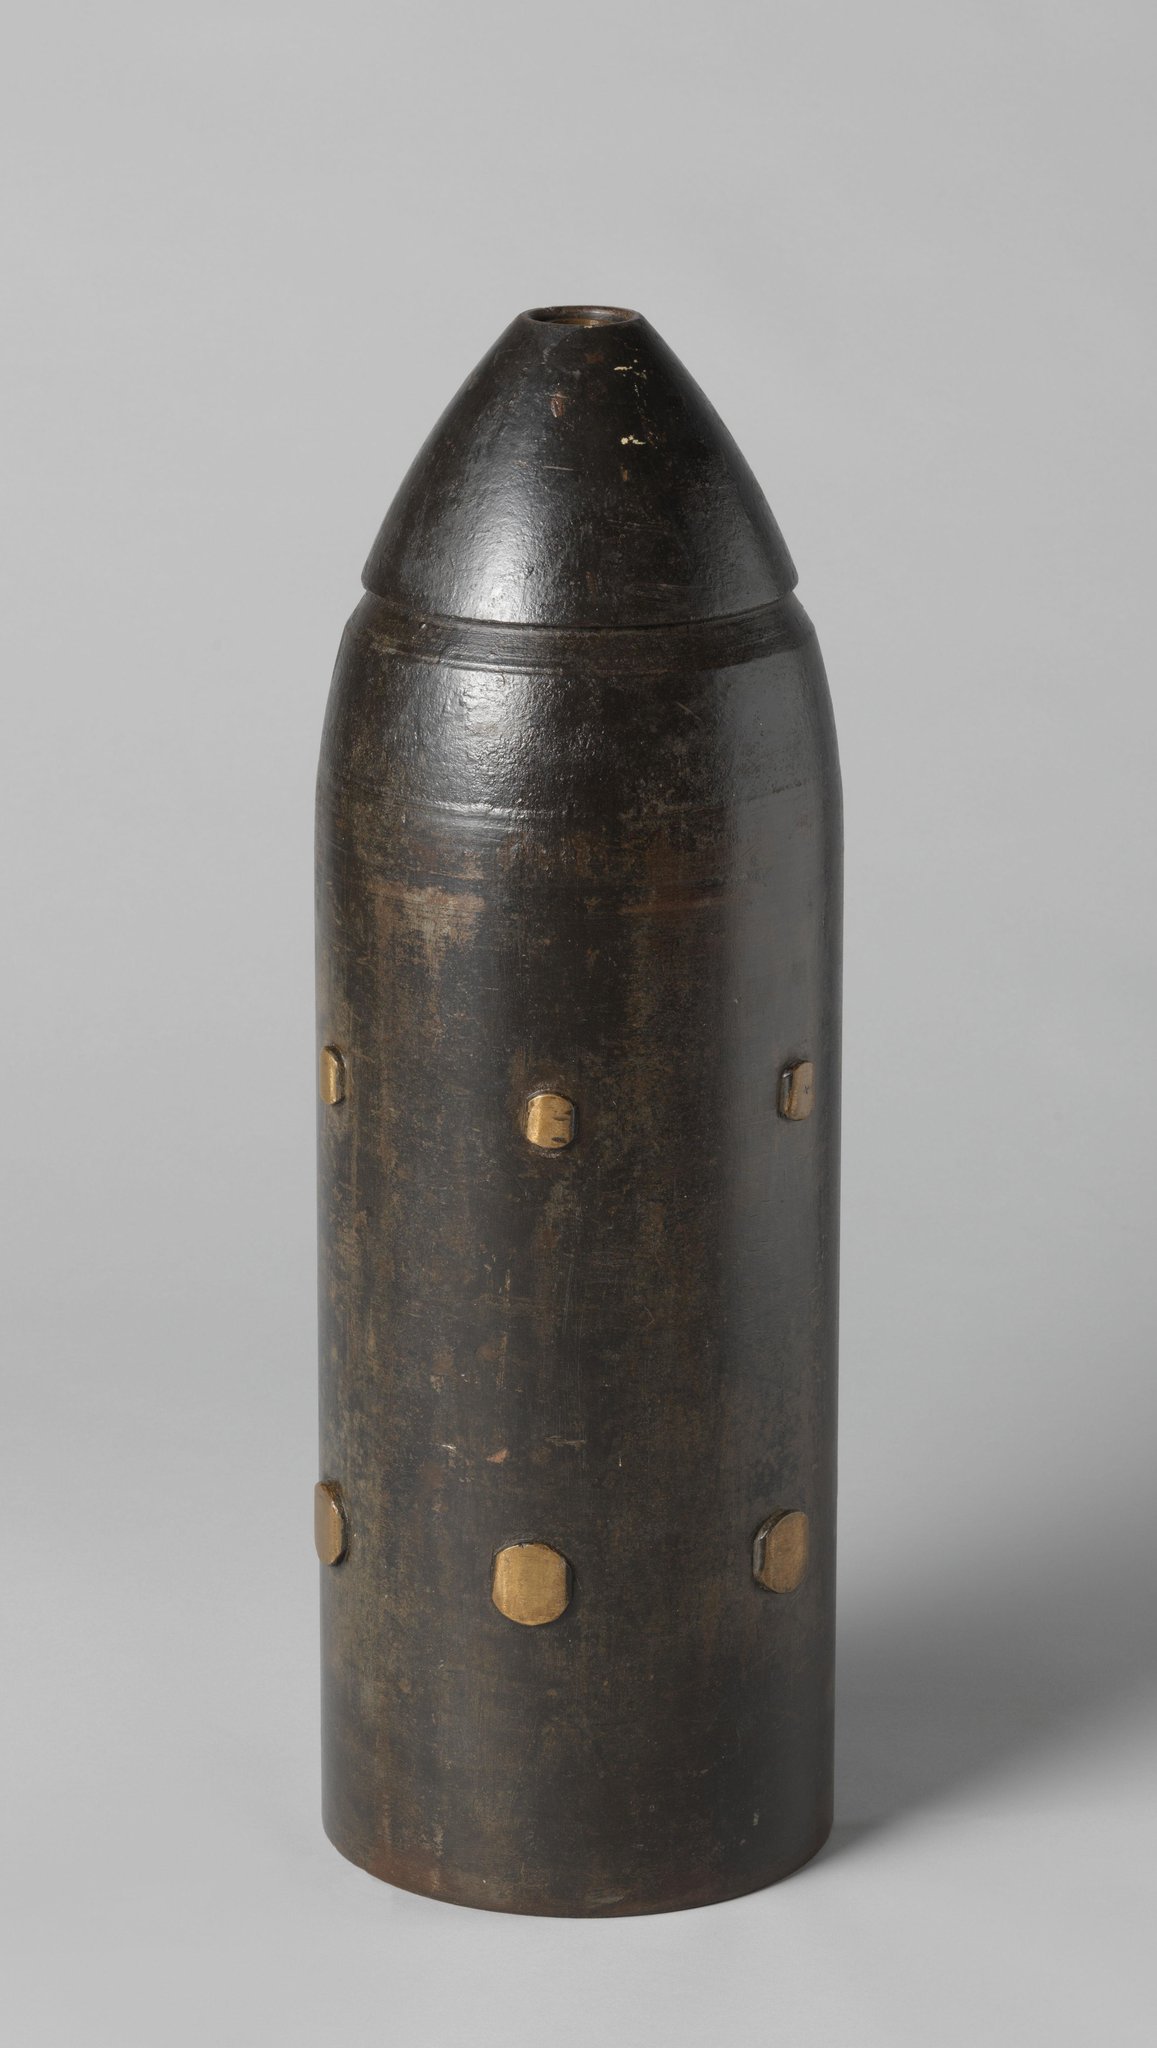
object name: grenade ammunition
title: 23-cm Shell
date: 1866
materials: brass, bronze, iron, lead, wood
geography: woolwich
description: Puntvormige 23 cm granaat. De granaat is 67.4 cm lang en heeft een kaliber van 226 mm. Hij heeft twee ringen ingeperste nokken voor een getrokken loop met zes trekkende velden en een buisgat in de neus, gevuld met een prop. Bovenaan is een groef voor de munitie-kraan aangebracht. Deze granaat is een Common shell MK I 9 inch RML.